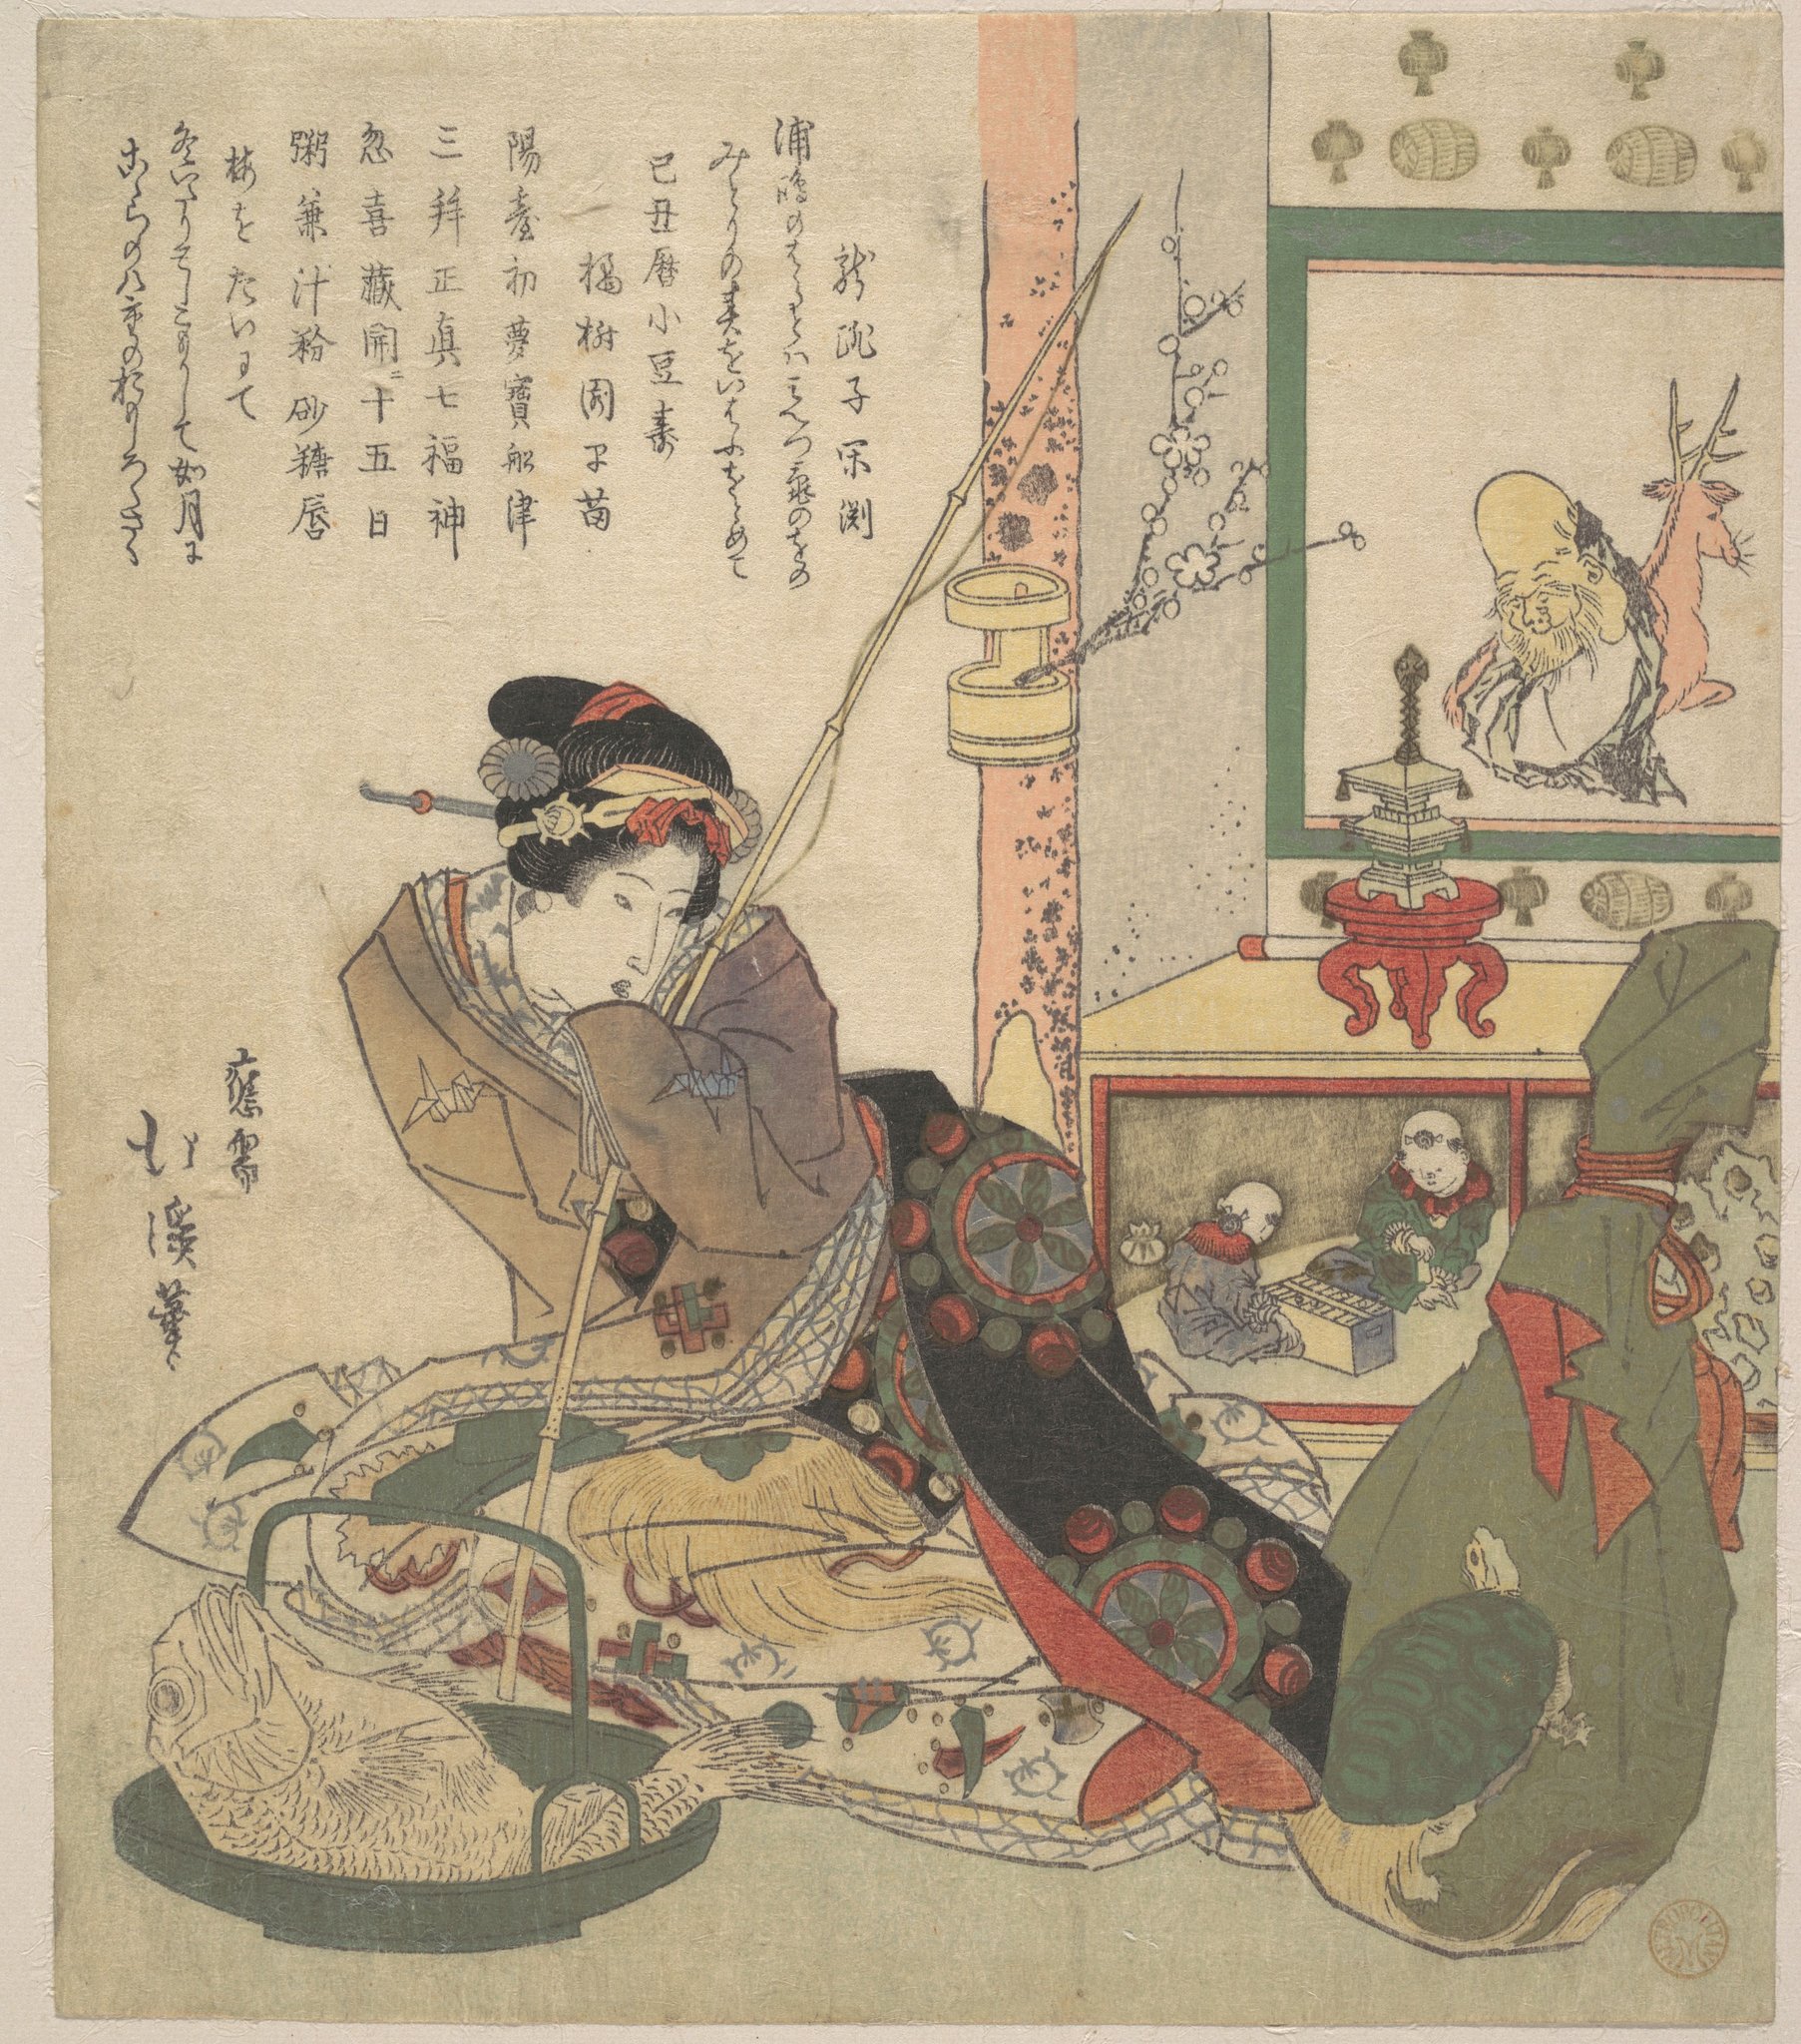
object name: print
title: Bijin Urashima and the Seven Fortune Beings (Shichi-fuku-jin)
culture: japanese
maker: totoya hokkei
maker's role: artist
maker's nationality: japanese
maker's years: 1780-1850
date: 1780-1850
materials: ink, paper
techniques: surimono, woodblock print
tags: women,fish,turtles